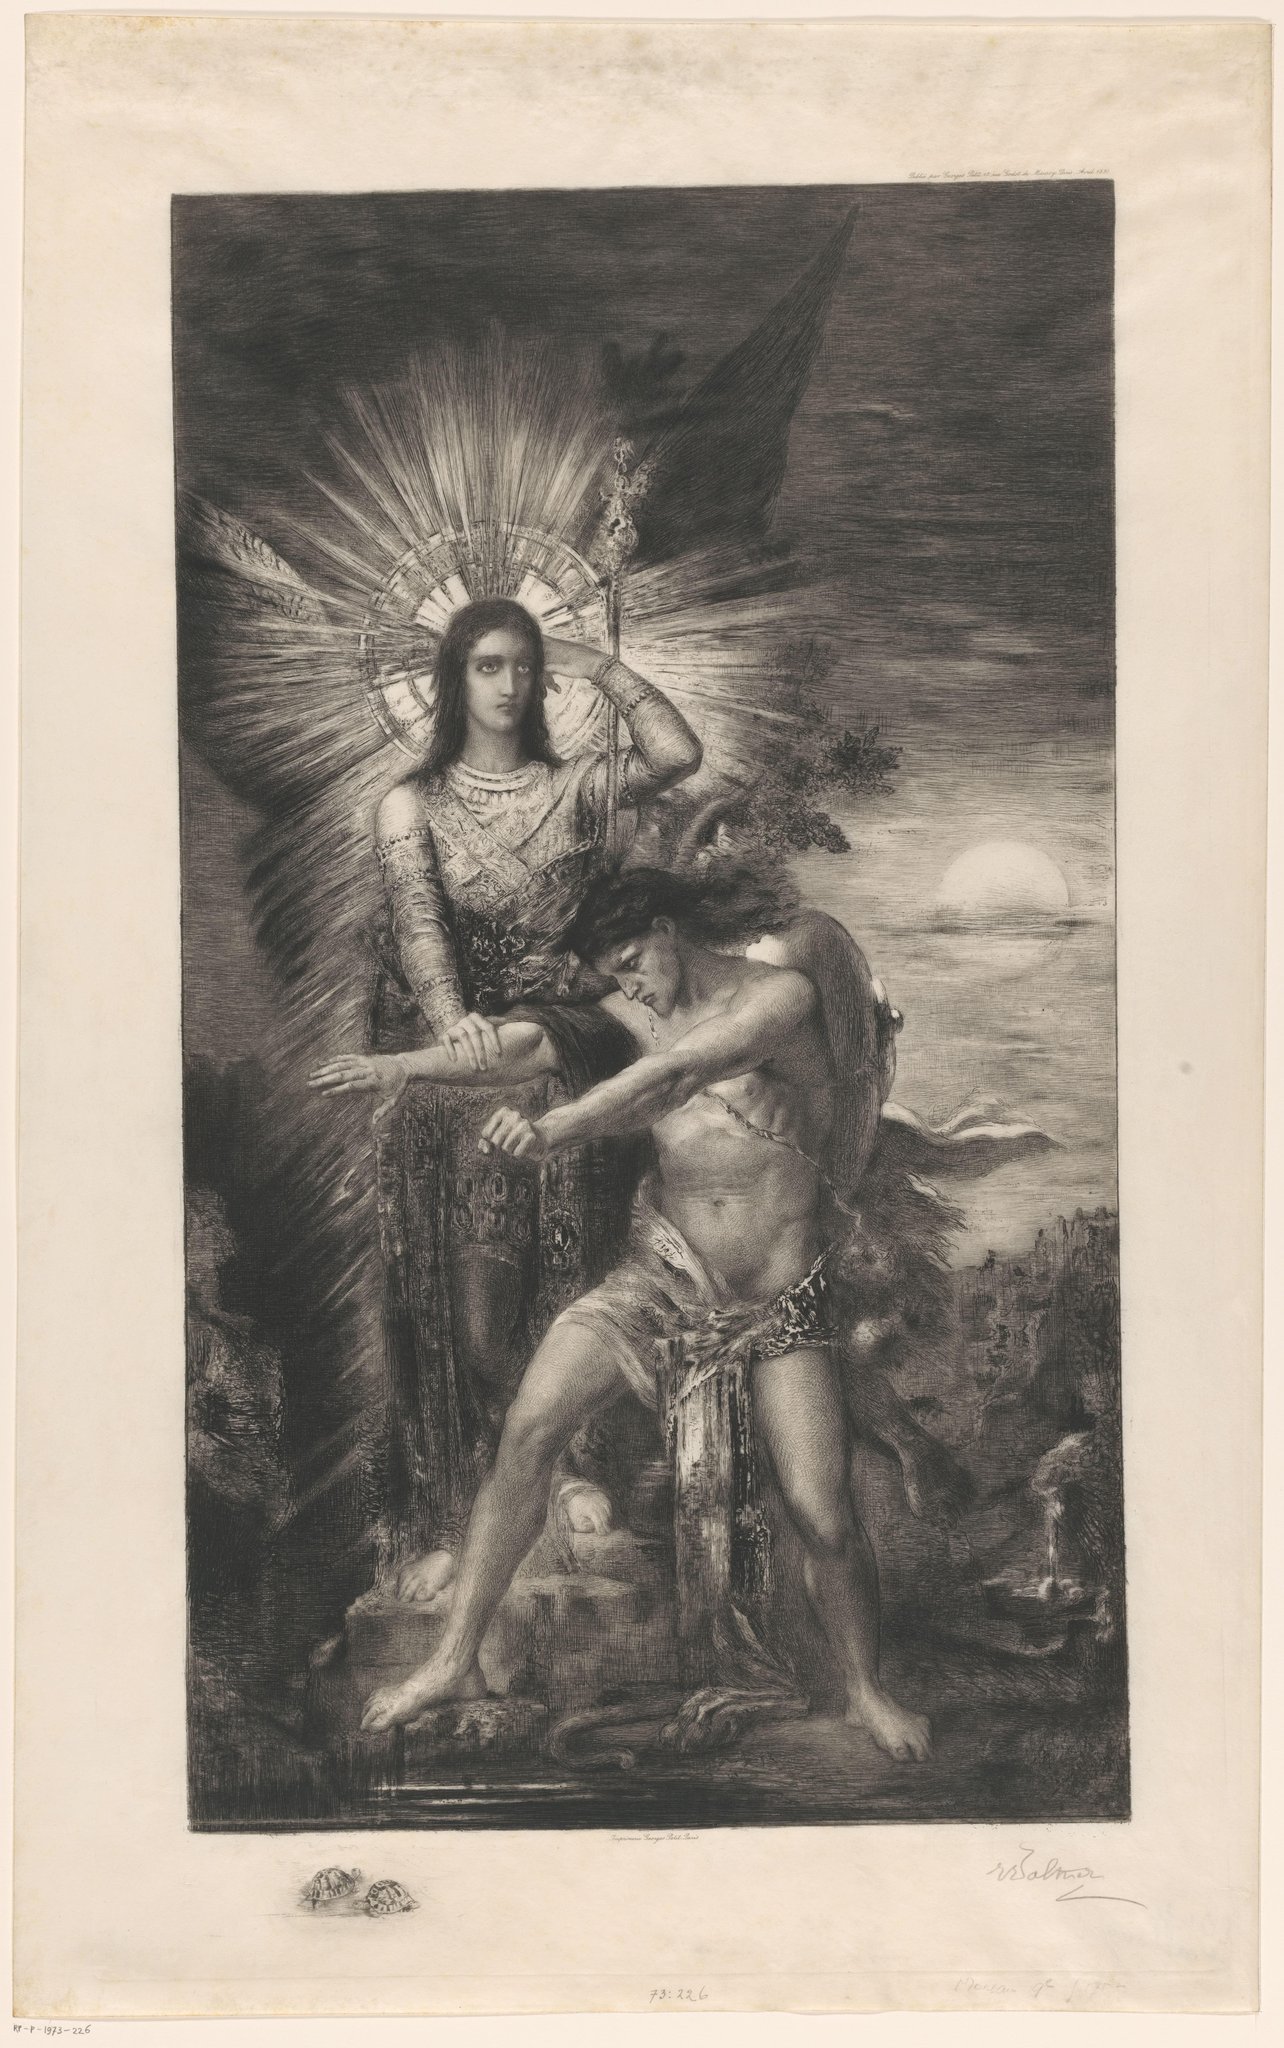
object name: print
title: Jacob en de engel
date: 1804-1898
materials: parchment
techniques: drypoint, etching, intaglio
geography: paris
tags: jacob wrestles with the angel (or man) till daybreak; jacob's thigh is put out of joint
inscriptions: inscription: ‘Moreau (?) 9e f 175-’, collector's mark: Lugt 2228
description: Het schilderij door Moreau bevindt zich in de collectie van het Metropolitan Museum te New York City, inv.nr. 1943.266.